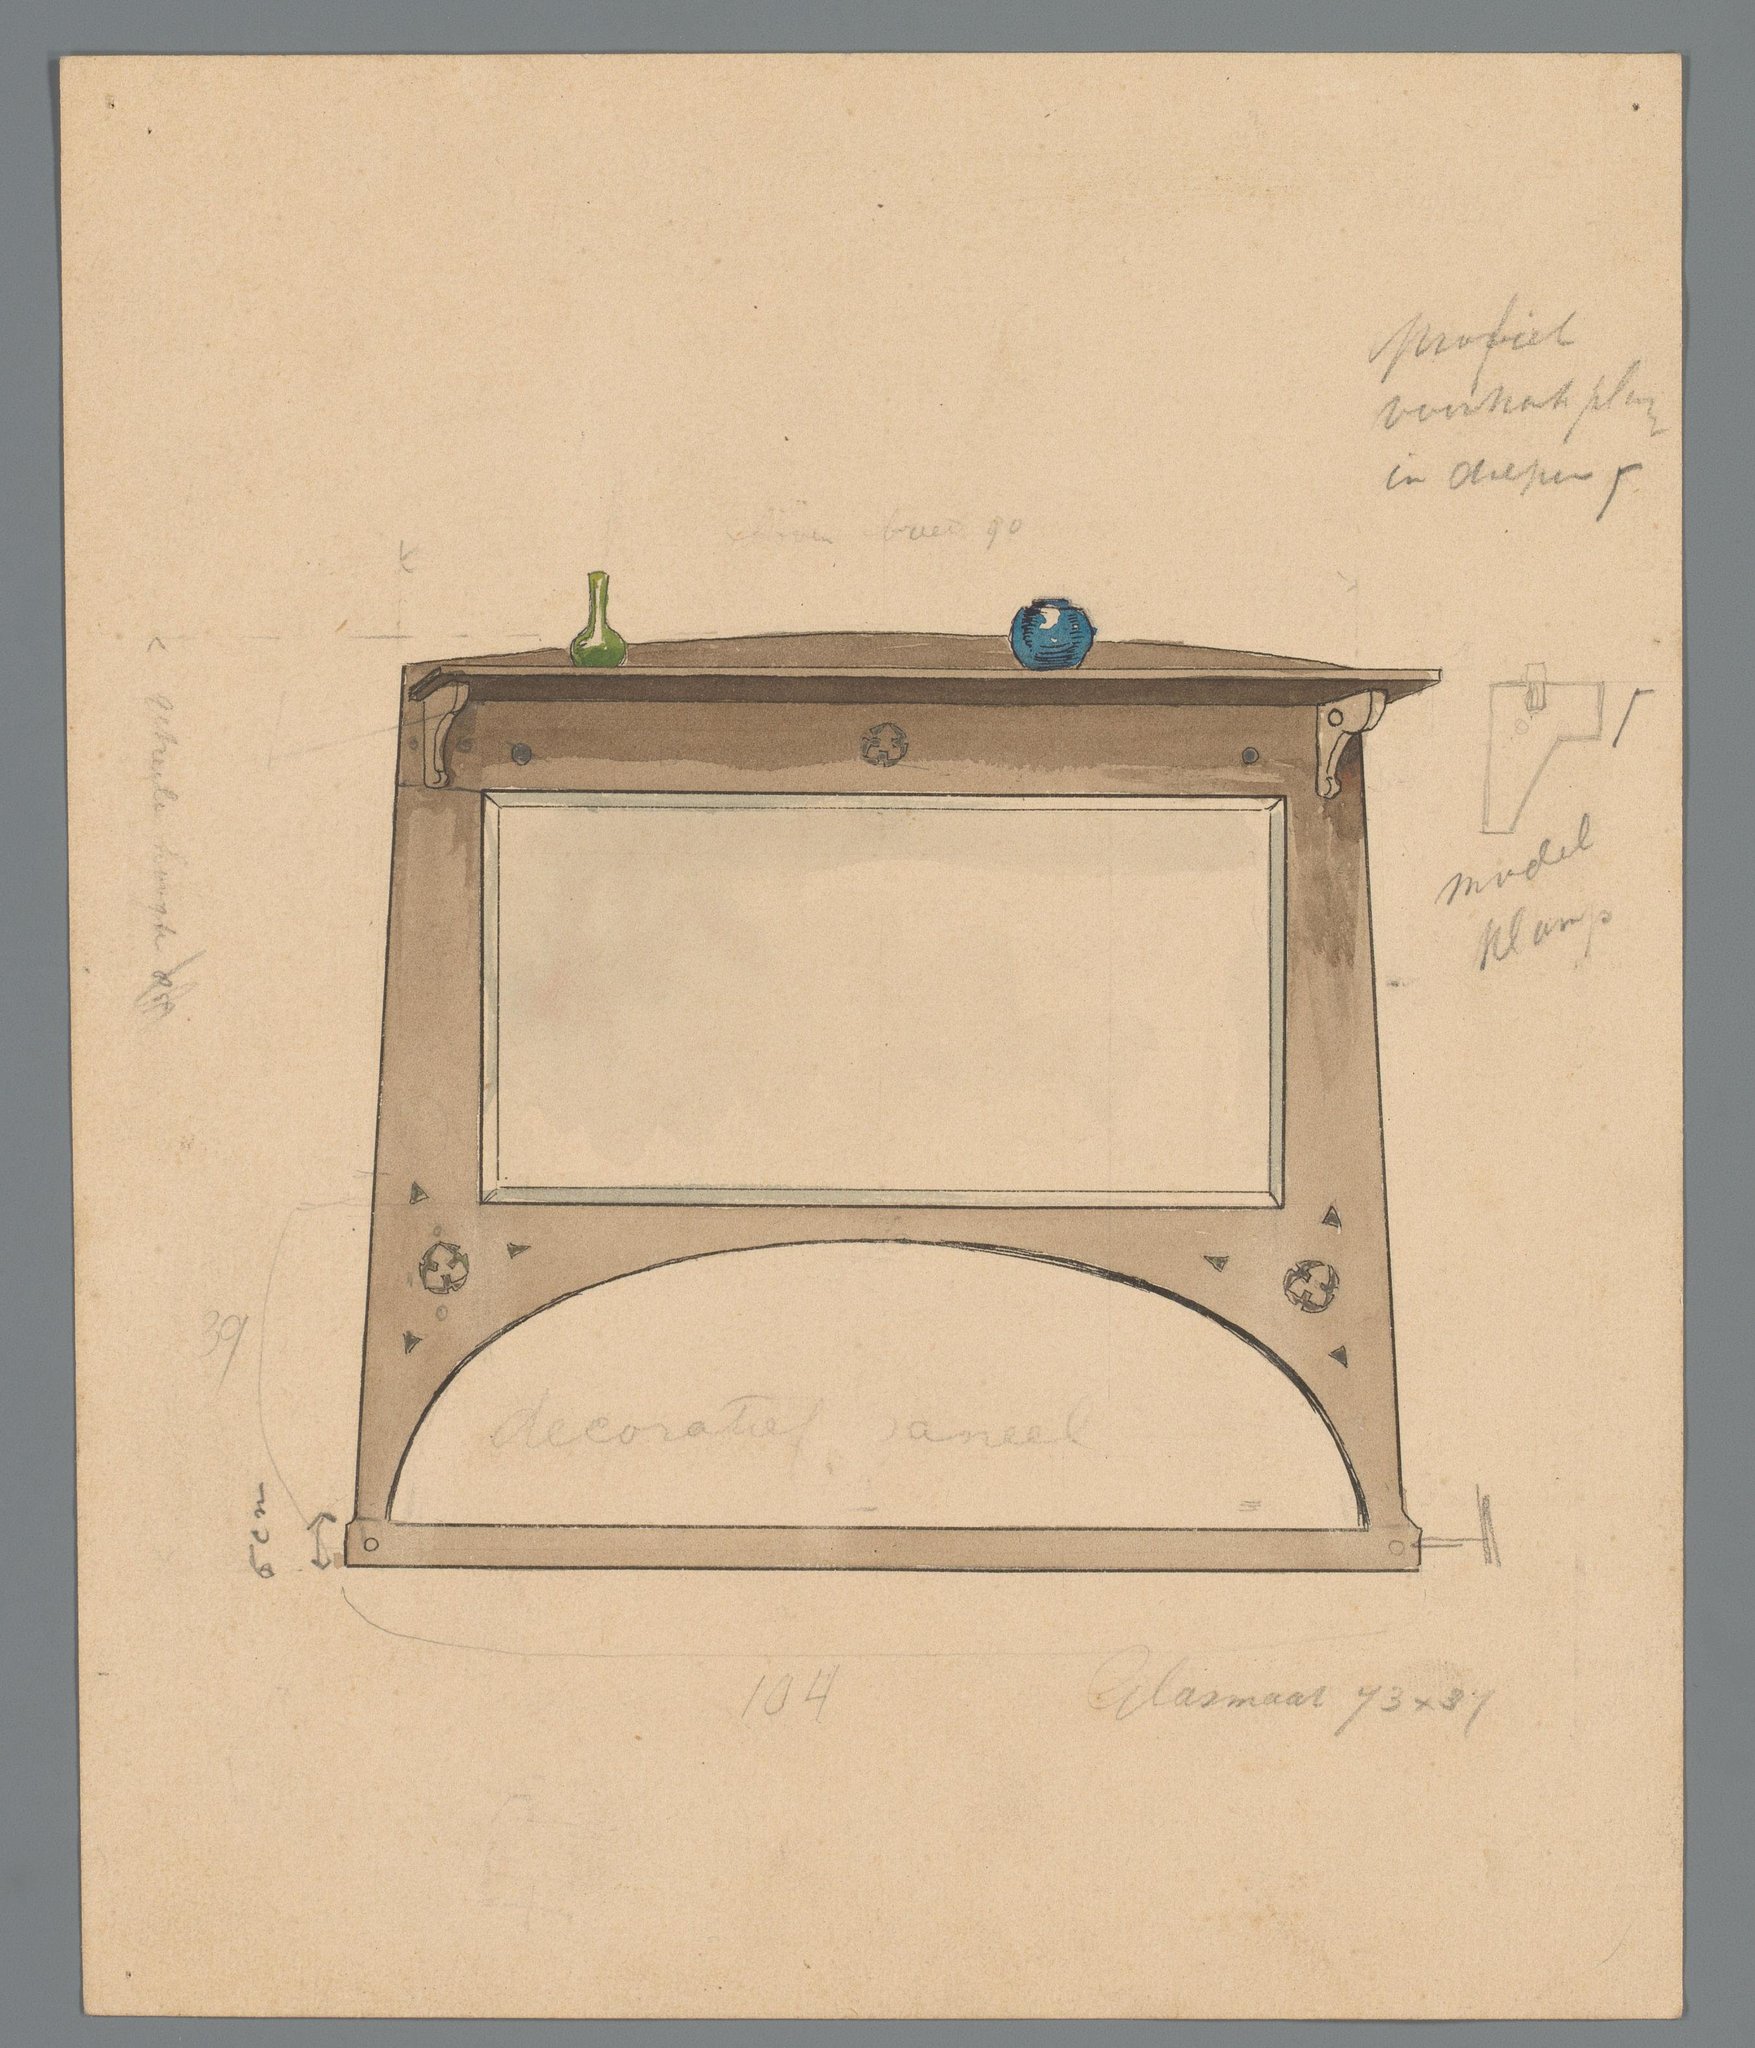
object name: design drawing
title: Ontwerp voor een meubel met spiegel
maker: gust van de wall perné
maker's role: draughtsman, painter, print maker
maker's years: 1877-1911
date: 1887-1911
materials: ink, paper, pencil, watercolor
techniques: brush, pen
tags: decorative furniture, mirror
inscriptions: collector's mark: Lugt 2228